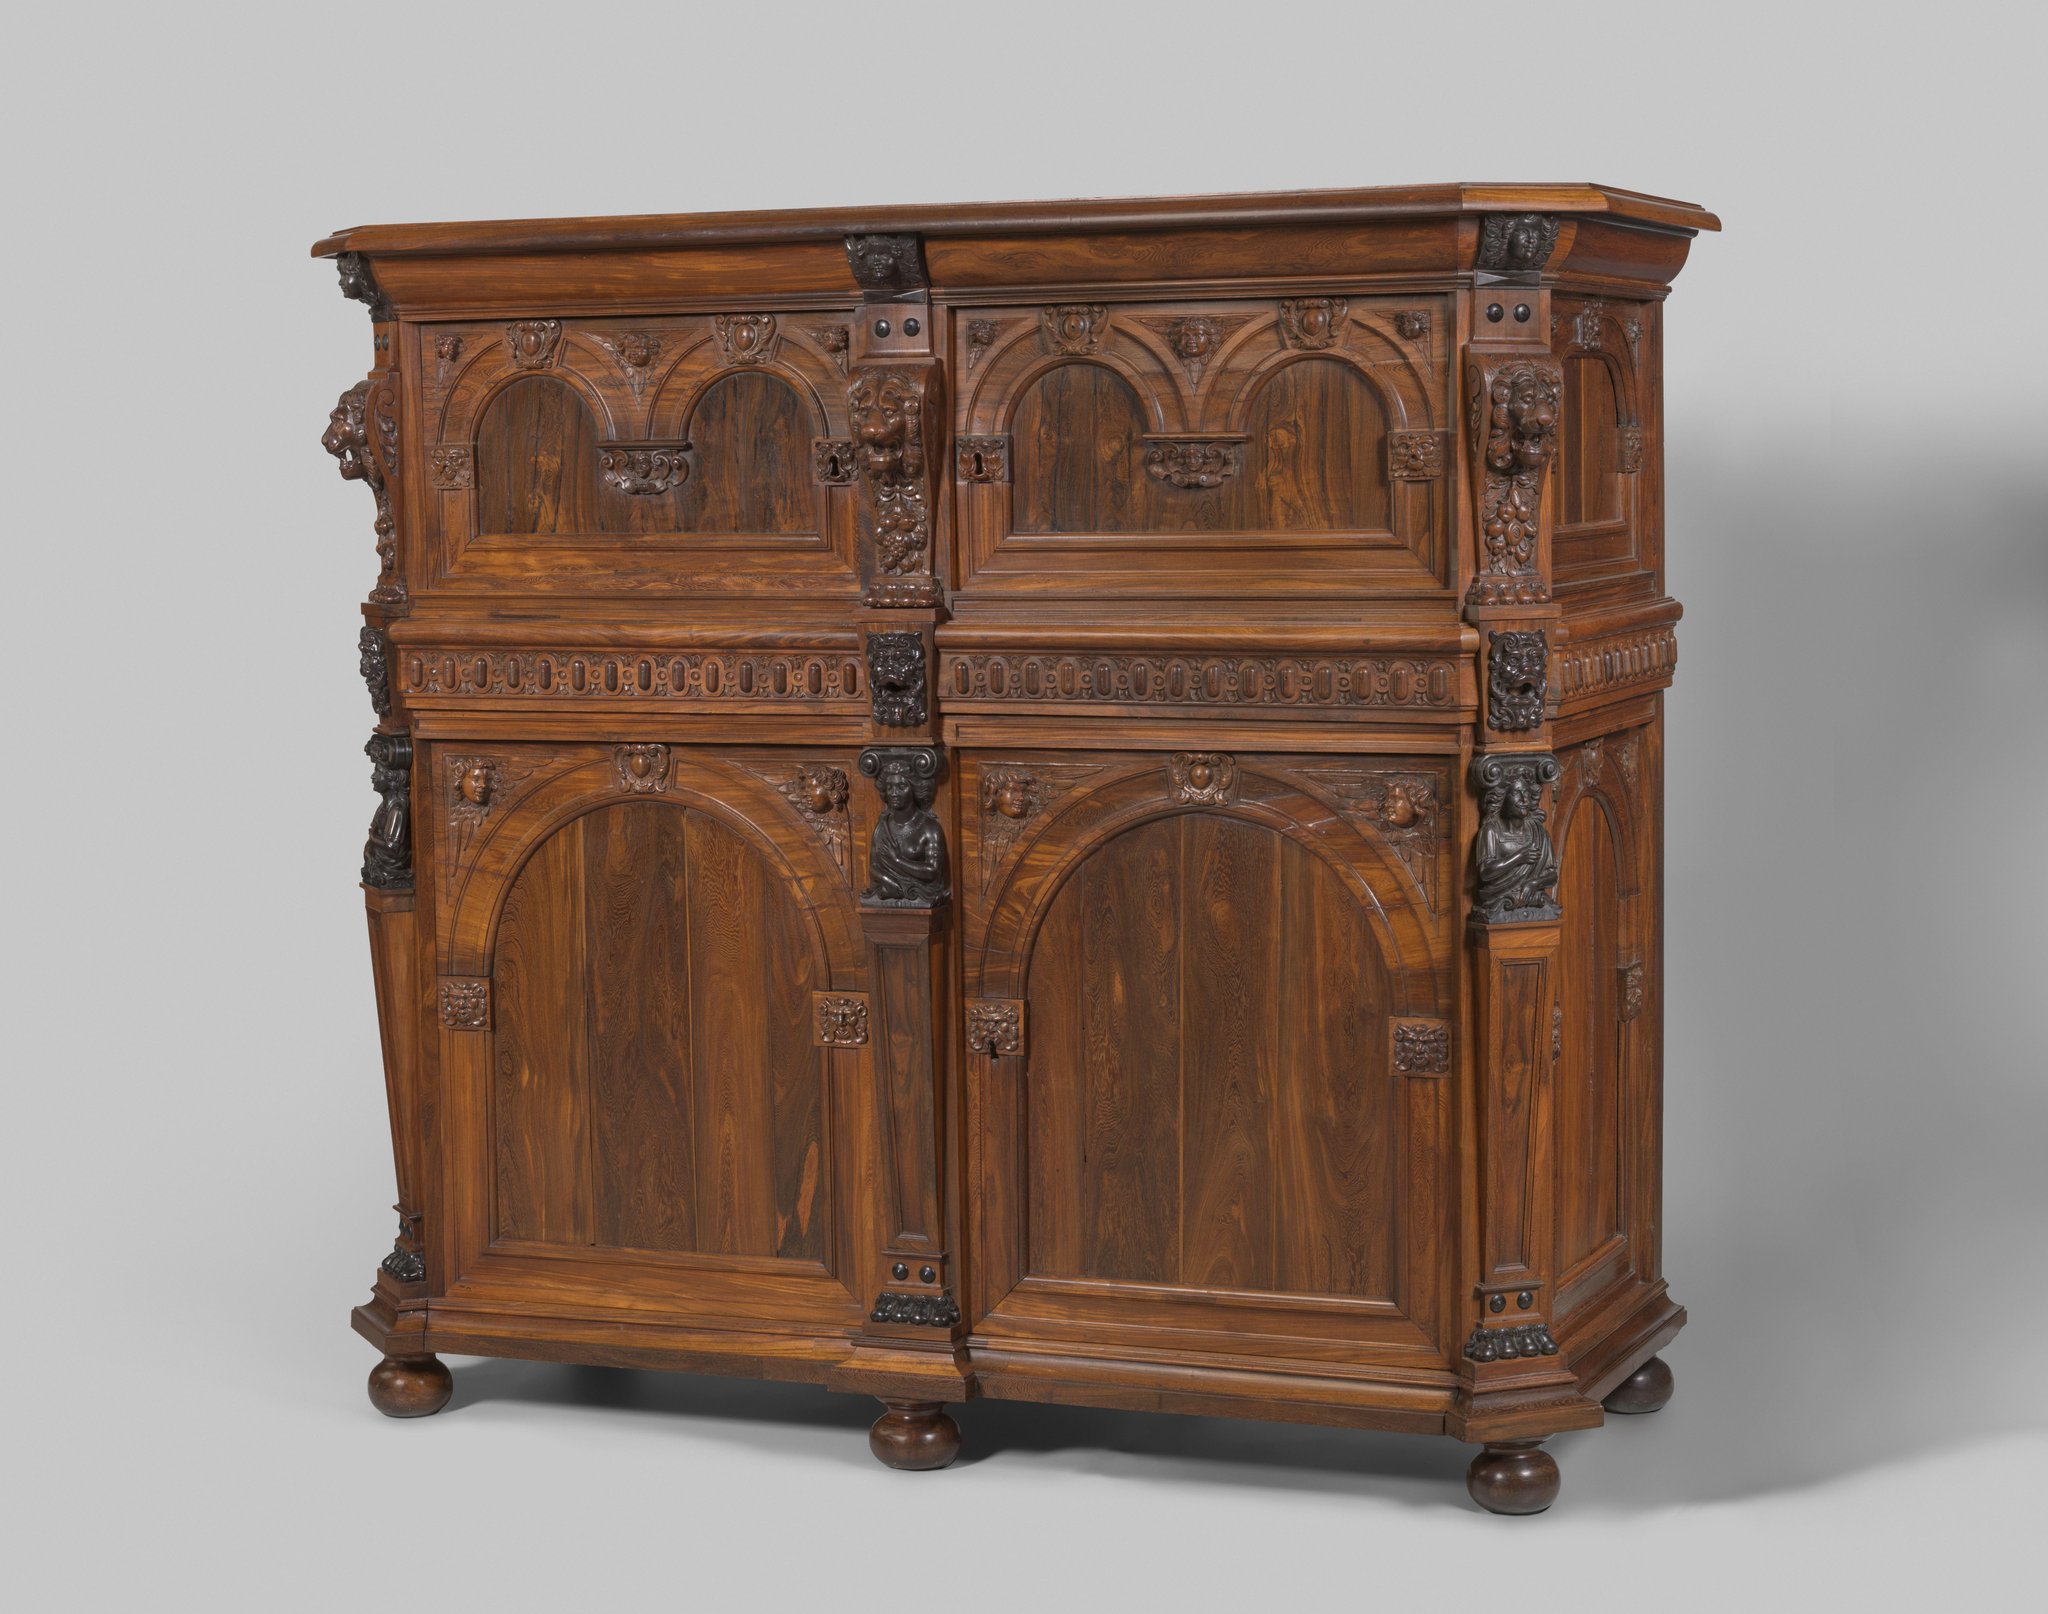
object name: furniture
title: Zeeuwse kast, belijmd met verschillende houtsoorten, op gedraaide bolpoten en versierd met hermatlanten en -kariatyden, cherubs, cartouches en maskers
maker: Anonymous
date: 1650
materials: wood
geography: northern netherlands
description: Cabinet. Cedar and oak, veneered with various exotic woods. Netherlands (Zeeland?), c. 1650. Legacy of A.A. des Tombe, 1903.